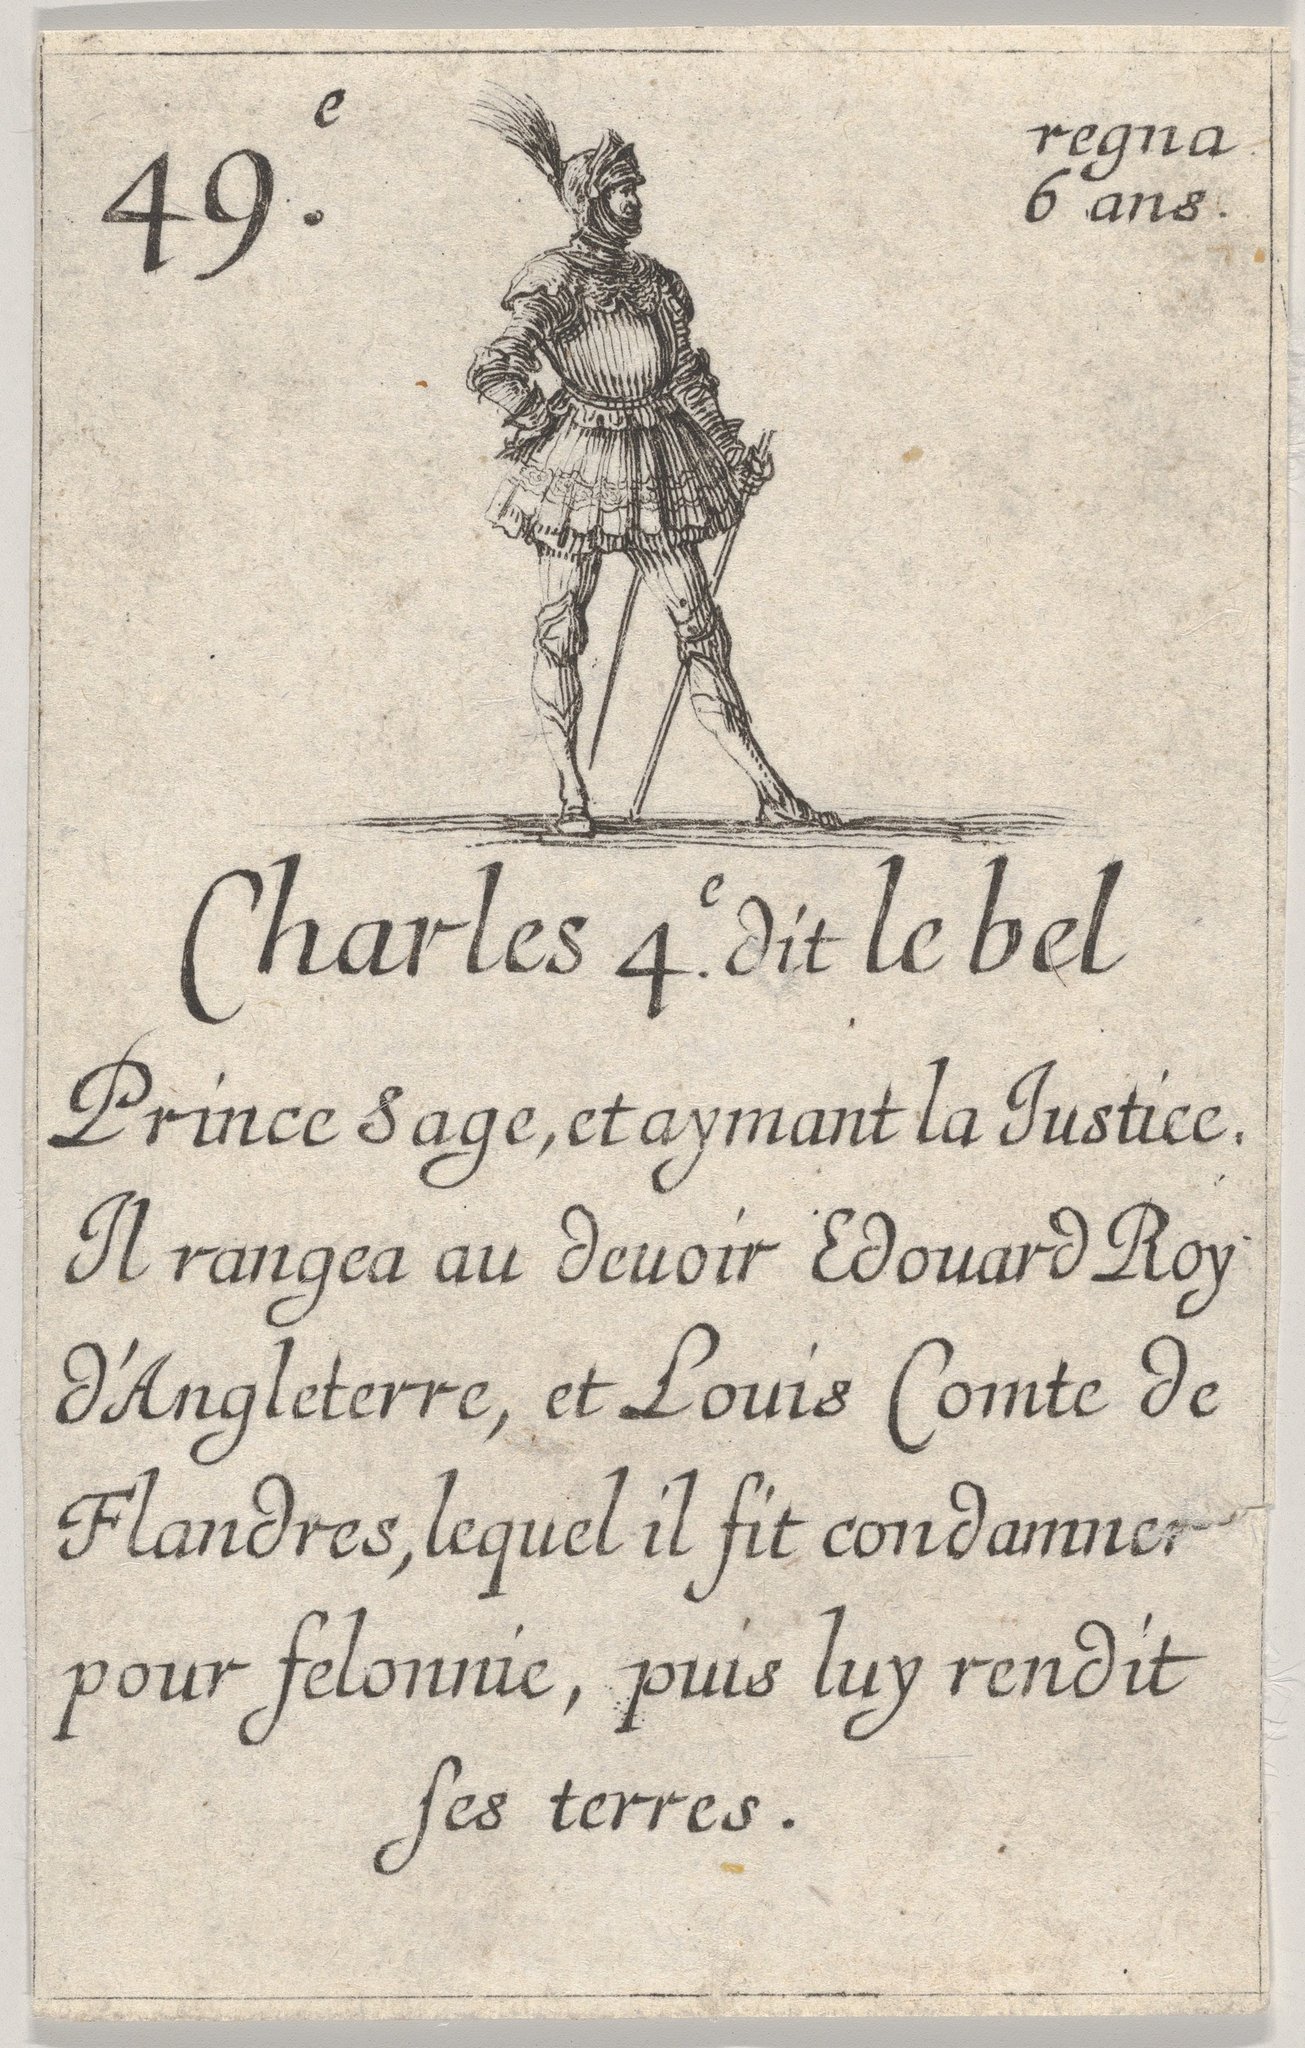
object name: print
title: Charles 4.e- dit le bel / Prince sage..., from "Game of the Kings of France" (Jeu des Rois de France)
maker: stefano della bella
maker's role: artist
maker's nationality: italian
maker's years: 1610-1664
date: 1644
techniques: etching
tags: kings